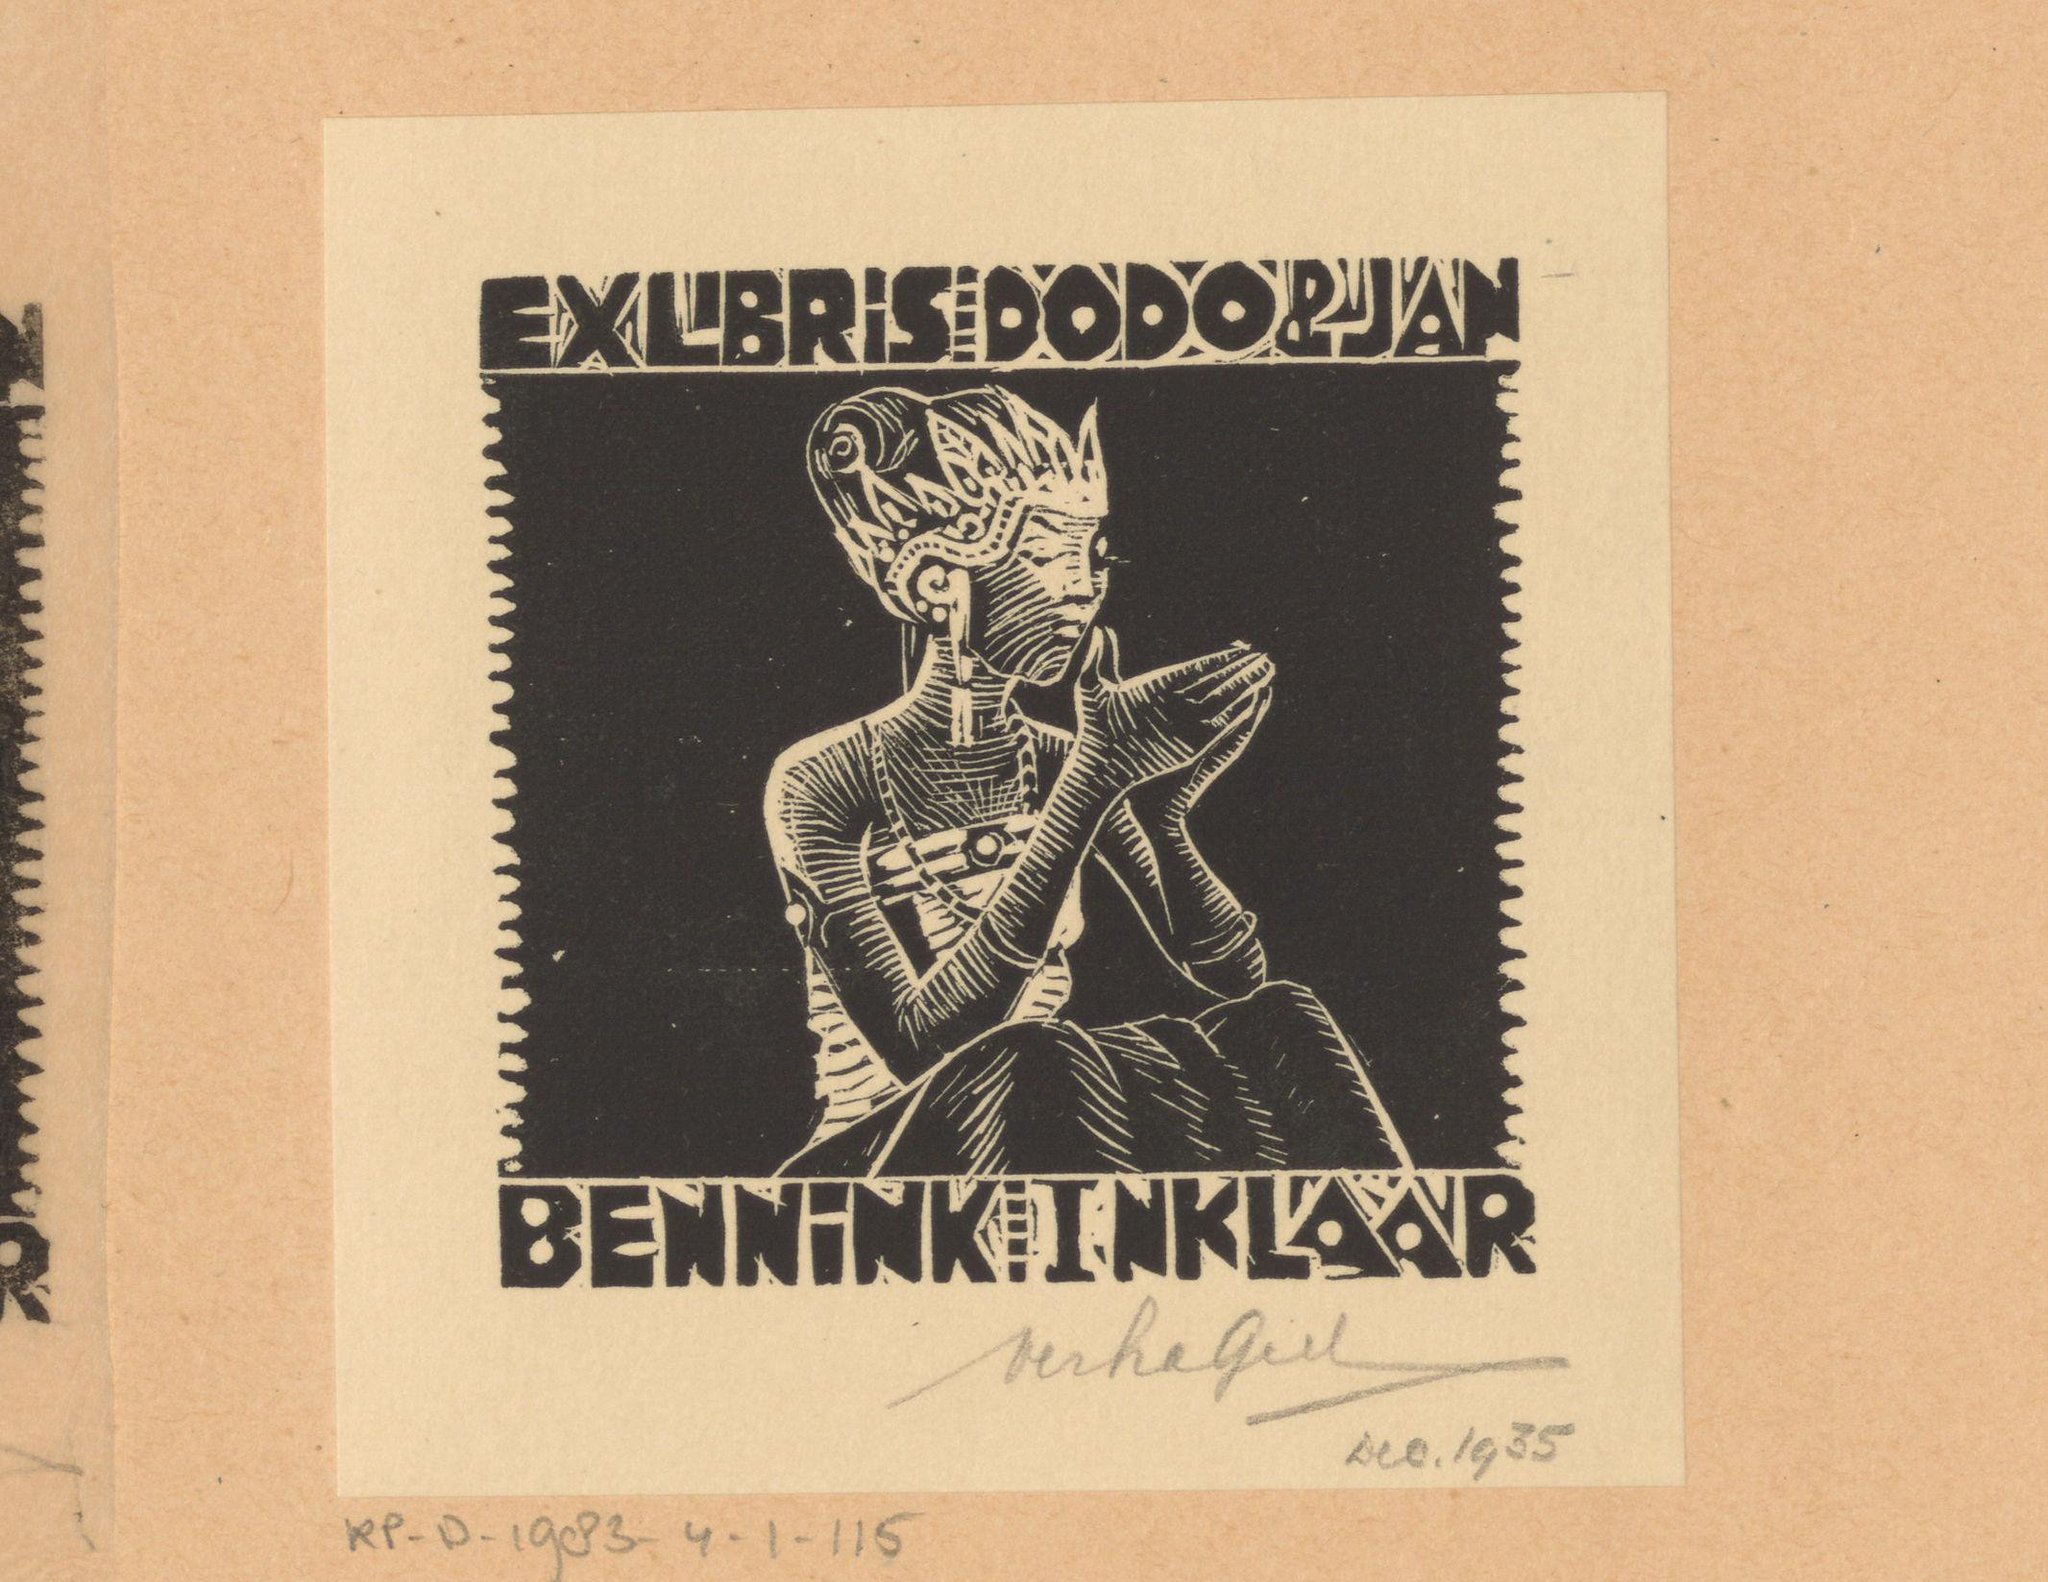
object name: bookplate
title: Ex libris van Dodo en Jan Bennink-Inklaar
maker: otto verhagen (i)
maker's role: draughtsman, print maker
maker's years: 1885-1951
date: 1912-1935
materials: paper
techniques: woodcut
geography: netherlands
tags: adolescent, young woman, maiden, folk costume, regional costume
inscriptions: inscription: ‘Houtsnede (kops-perenhout), jaar (...) New York, 1950.’, signature, date and inscription: ‘Verhagen/ Dec. 1935’, inscription: ‘Druk op simili-Japon’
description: Betekenis van de voorstelling is de Oosterse beschaving die een groet (Sembah) aan de Westerse beschaving brengt. Het ex libris is afgebeeld met een druk van het originele blok in "Dutch bookplates" van D. Giltay Veth, New York, 1950.